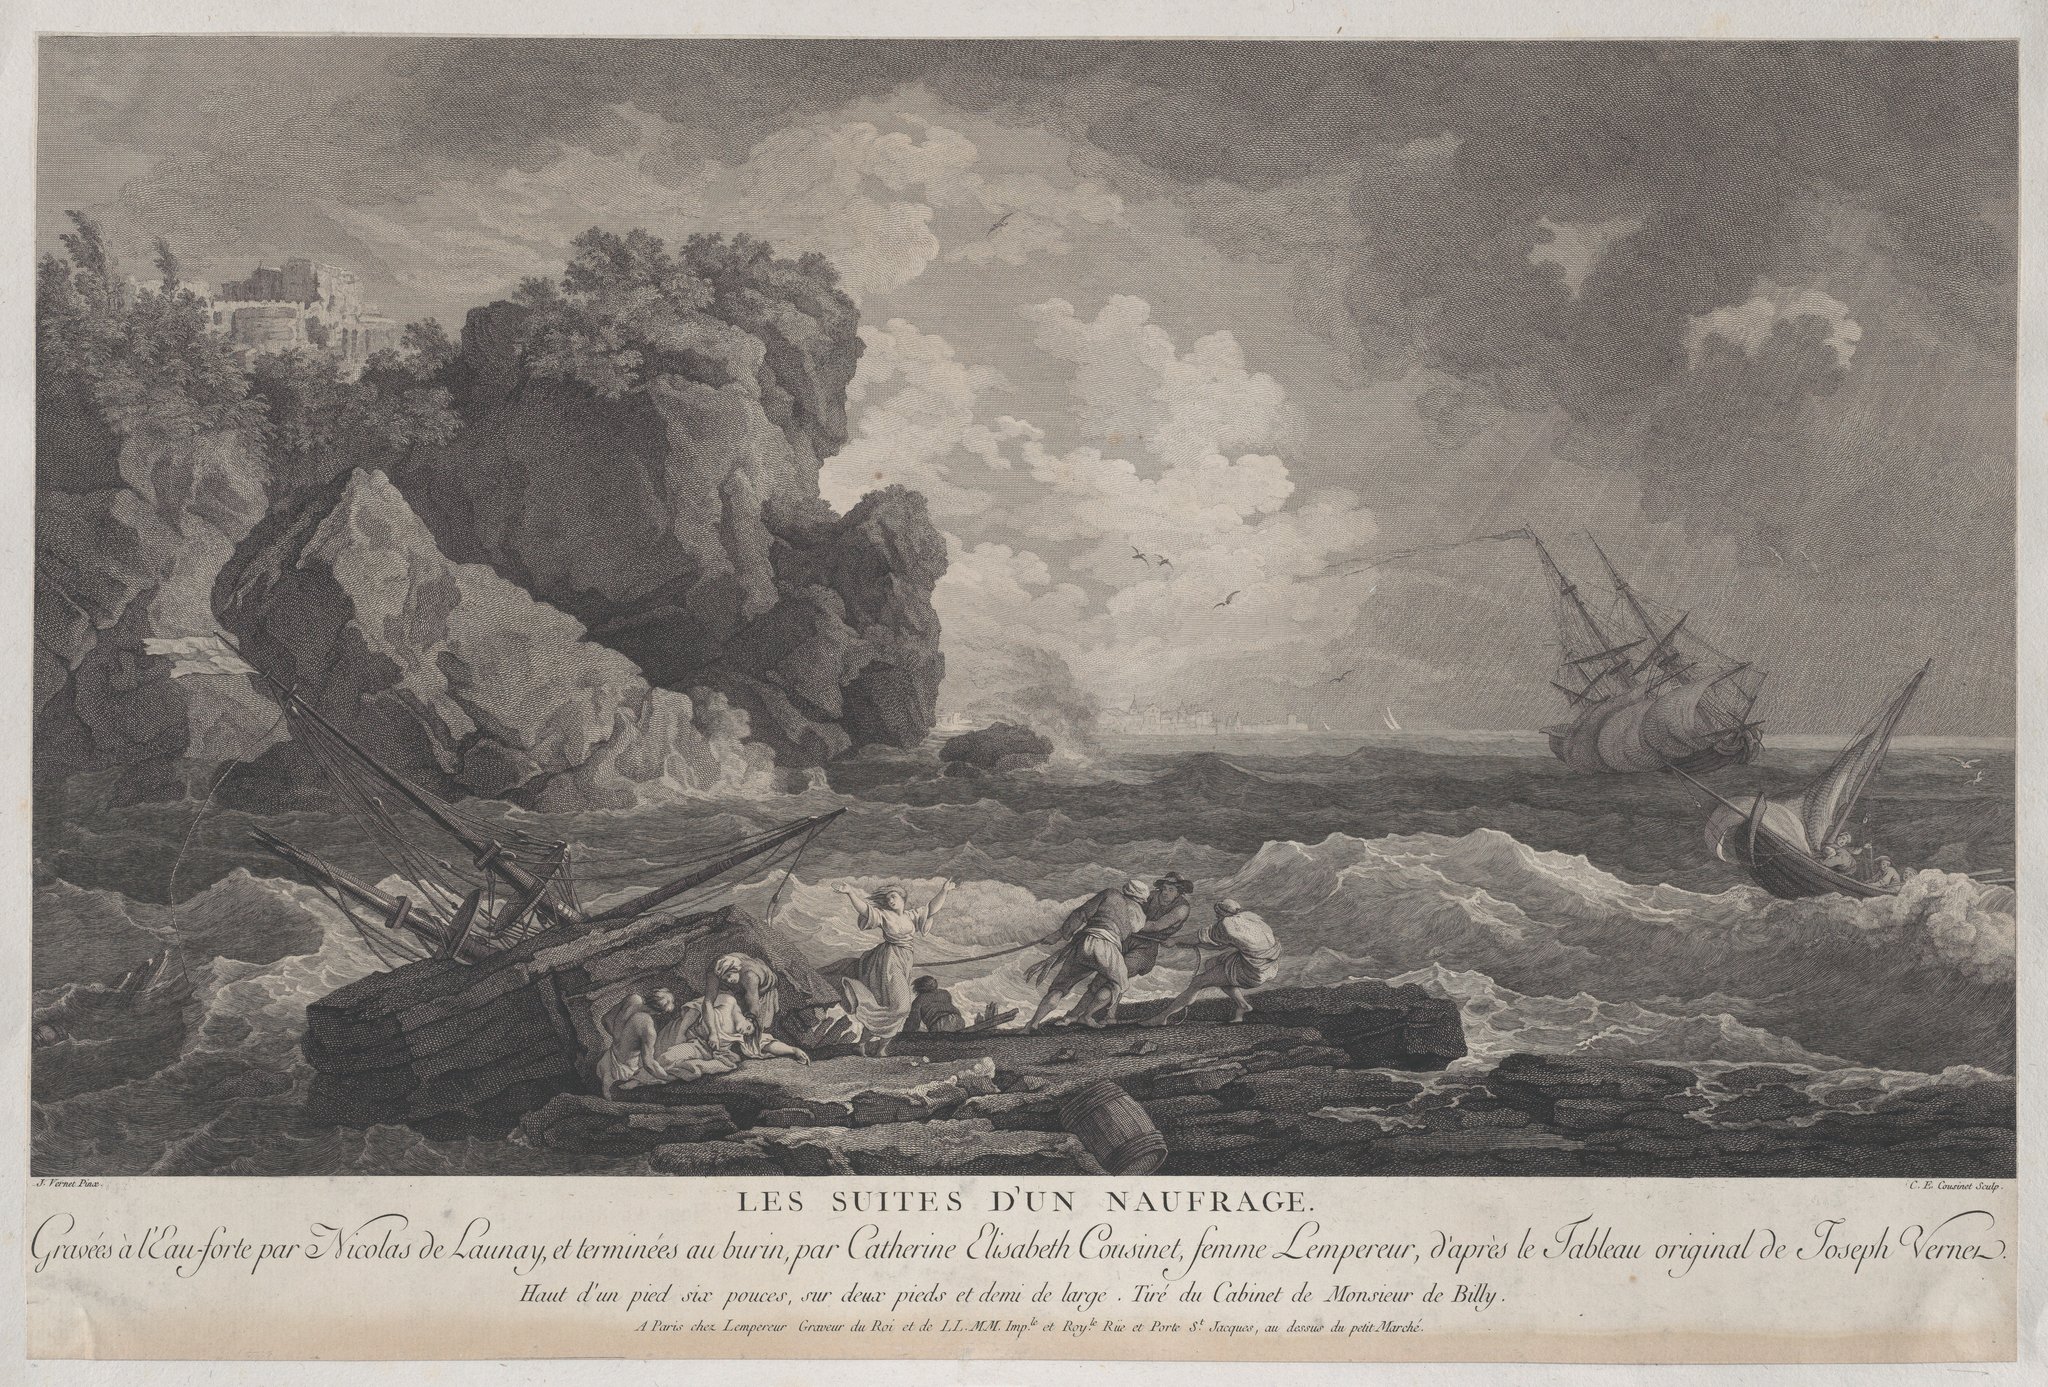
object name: print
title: The Remains of a Shipwreck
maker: joseph vernet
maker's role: artist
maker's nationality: french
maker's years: 1714-1789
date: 1750-1800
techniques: engraving